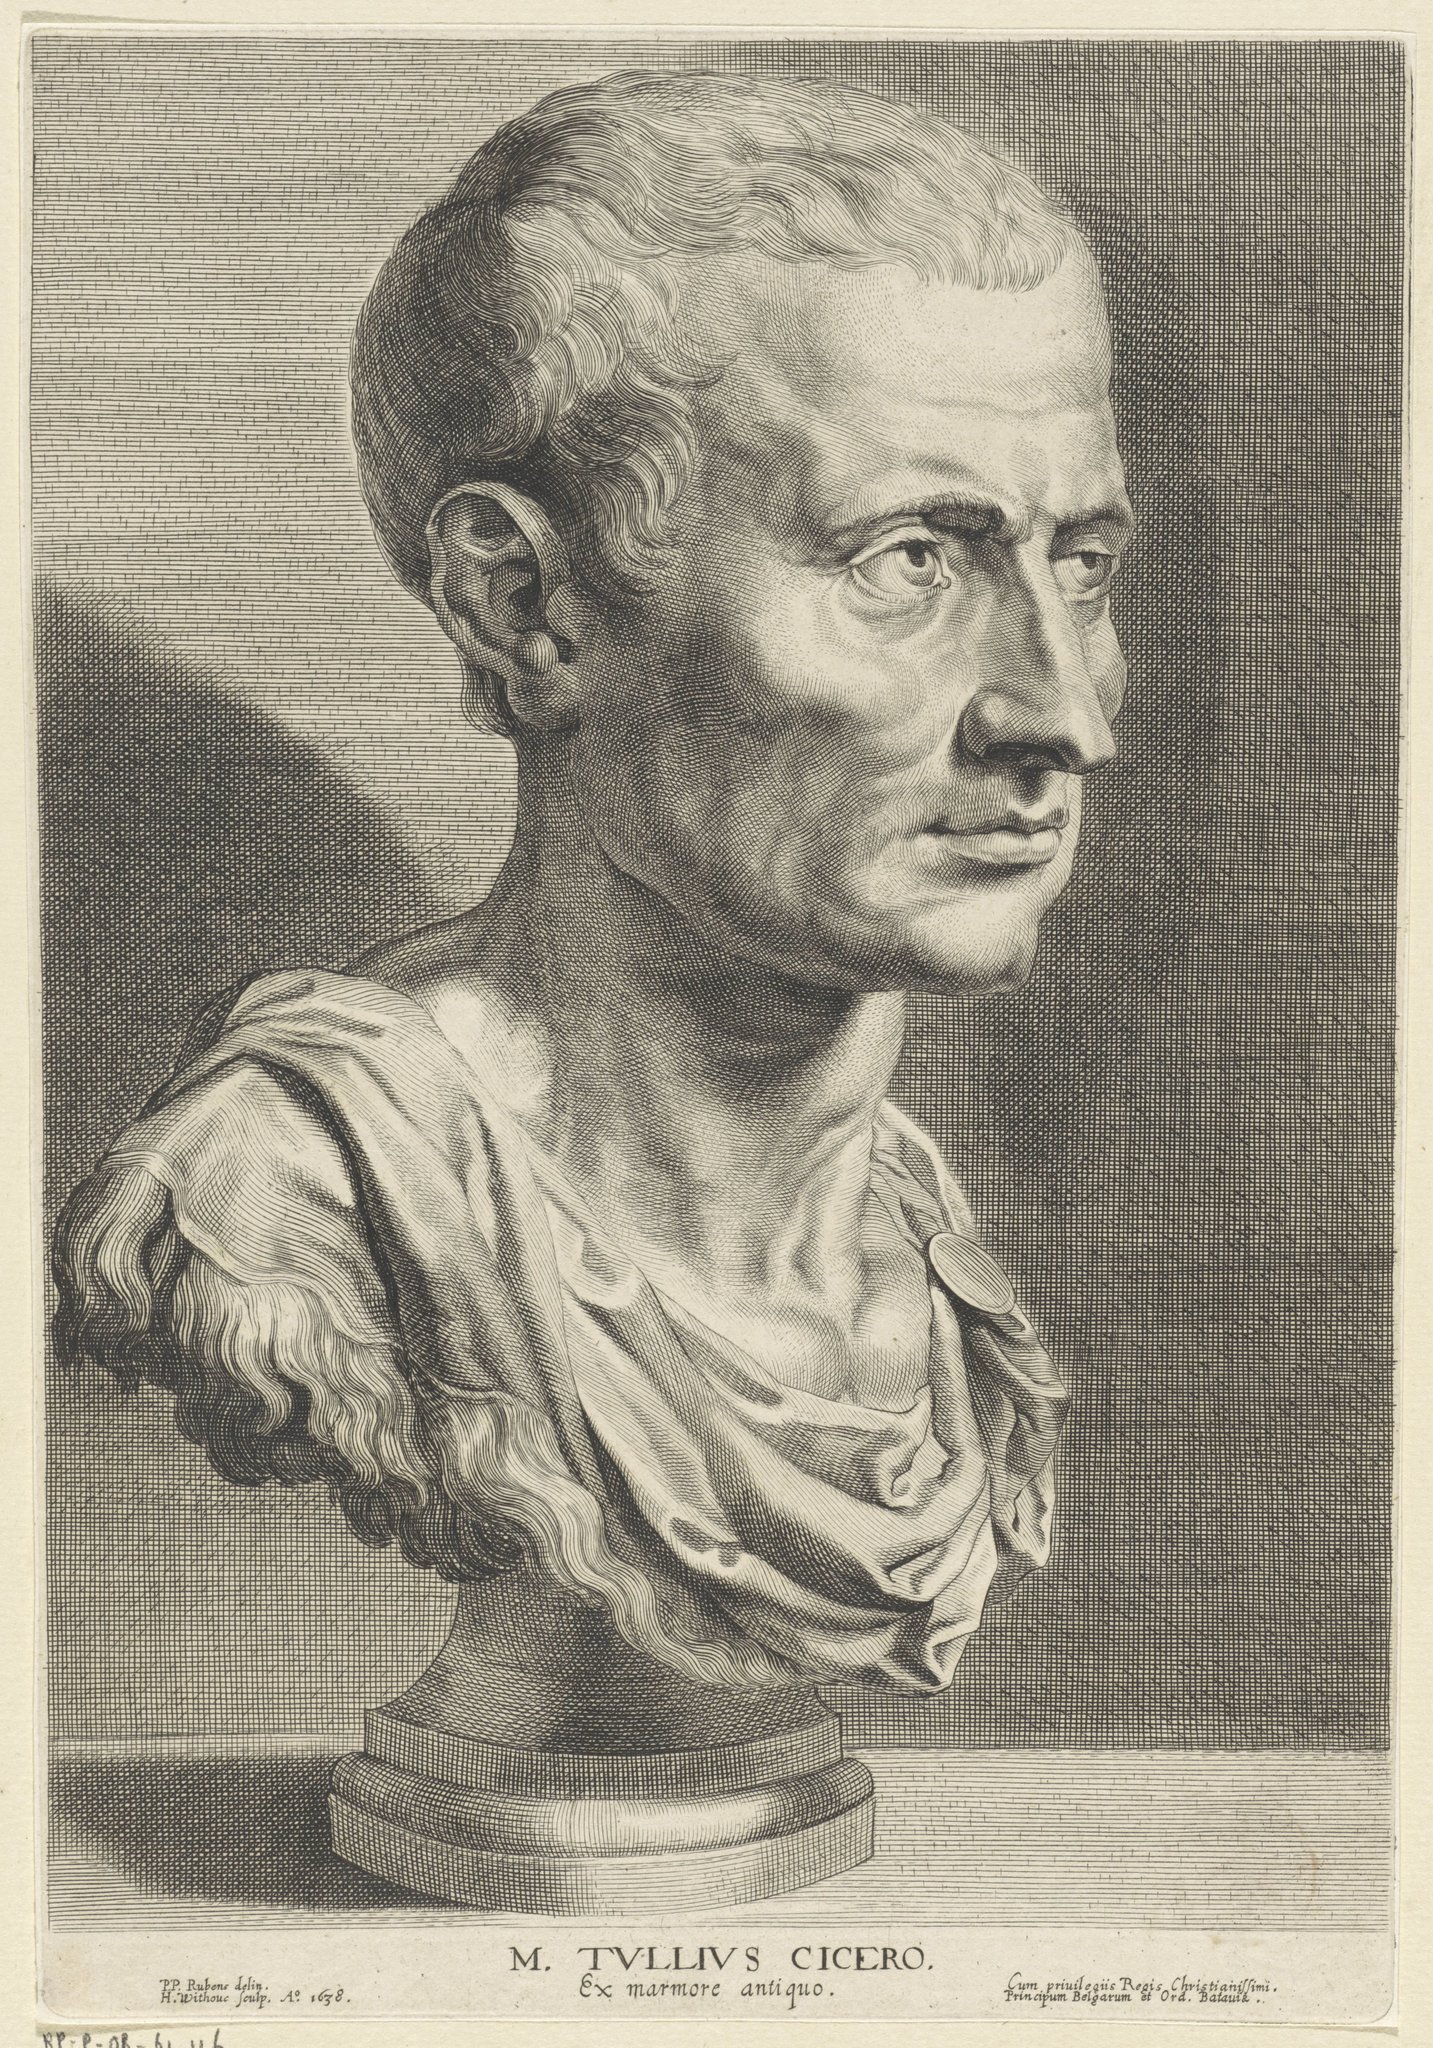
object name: print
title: Buste van Marcus Tullius Cicero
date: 1638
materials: paper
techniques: engraving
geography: antwerp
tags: marcus tullius cicero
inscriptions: collector's mark: Lugt 240